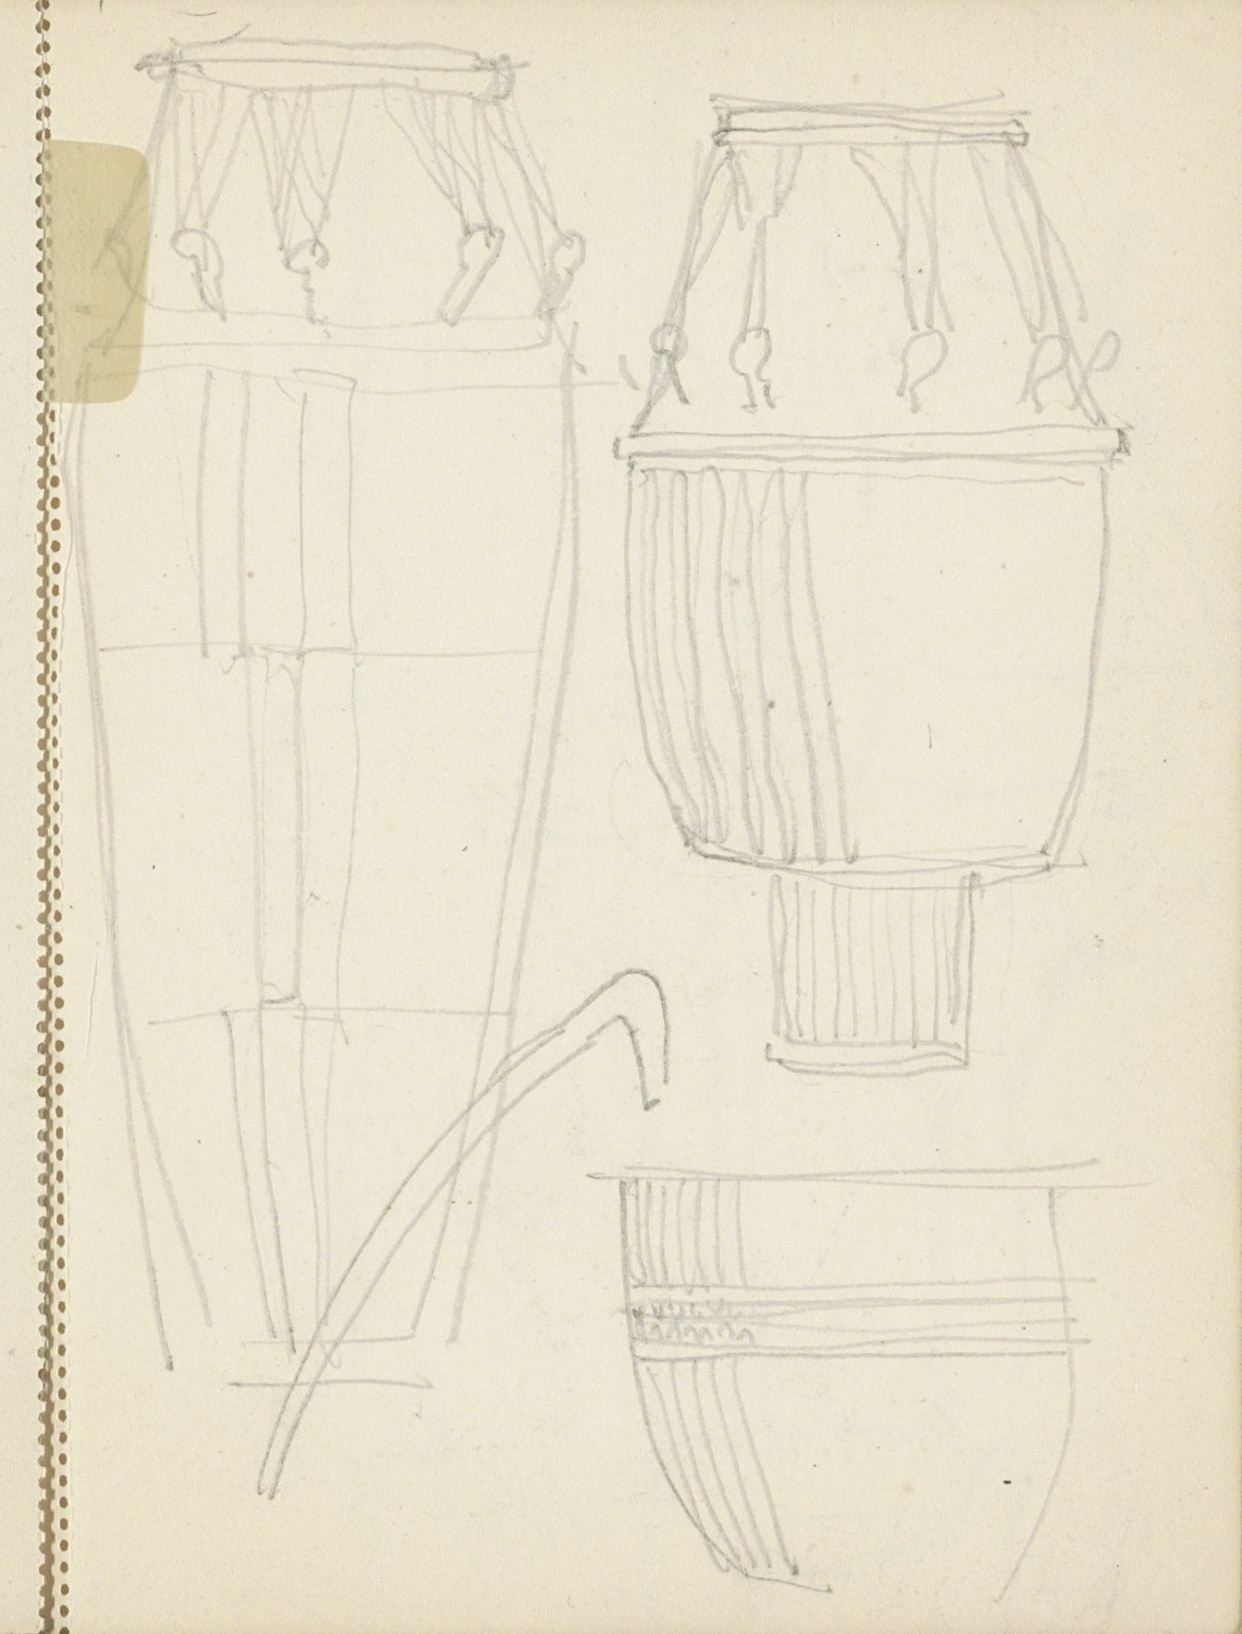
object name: sketchbook leaf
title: Afrikaanse trommels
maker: reijer stolk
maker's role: draughtsman, print maker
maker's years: 1896-1945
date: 1916-1945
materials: paper, pencil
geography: africa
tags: drum (musical instrument)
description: Blad 43 recto uit een schetsboek met 60 bladen.